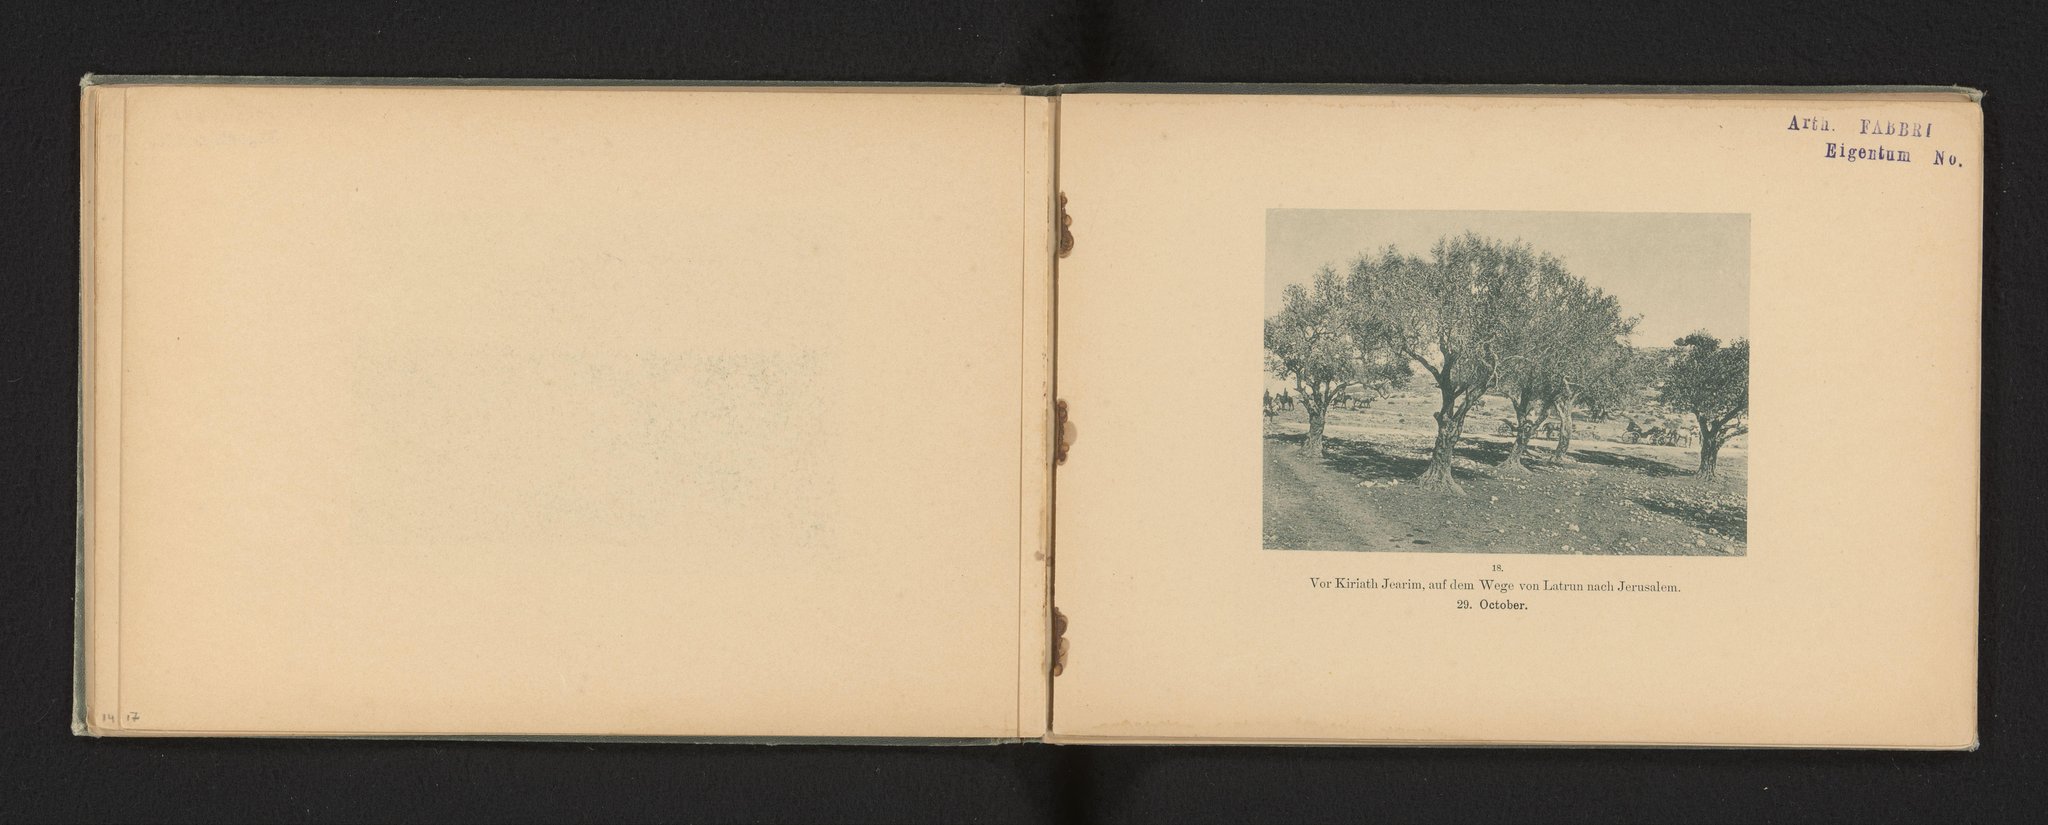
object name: page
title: Vor Kiriath Jearim, auf dem Wege von Latrun nach Jerusalem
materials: paper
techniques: photograph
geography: israel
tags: trees, landscapes, road, path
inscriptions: collector's mark: ‘Arth. FABBRI/ Eigentum No.’, number: ‘18.’